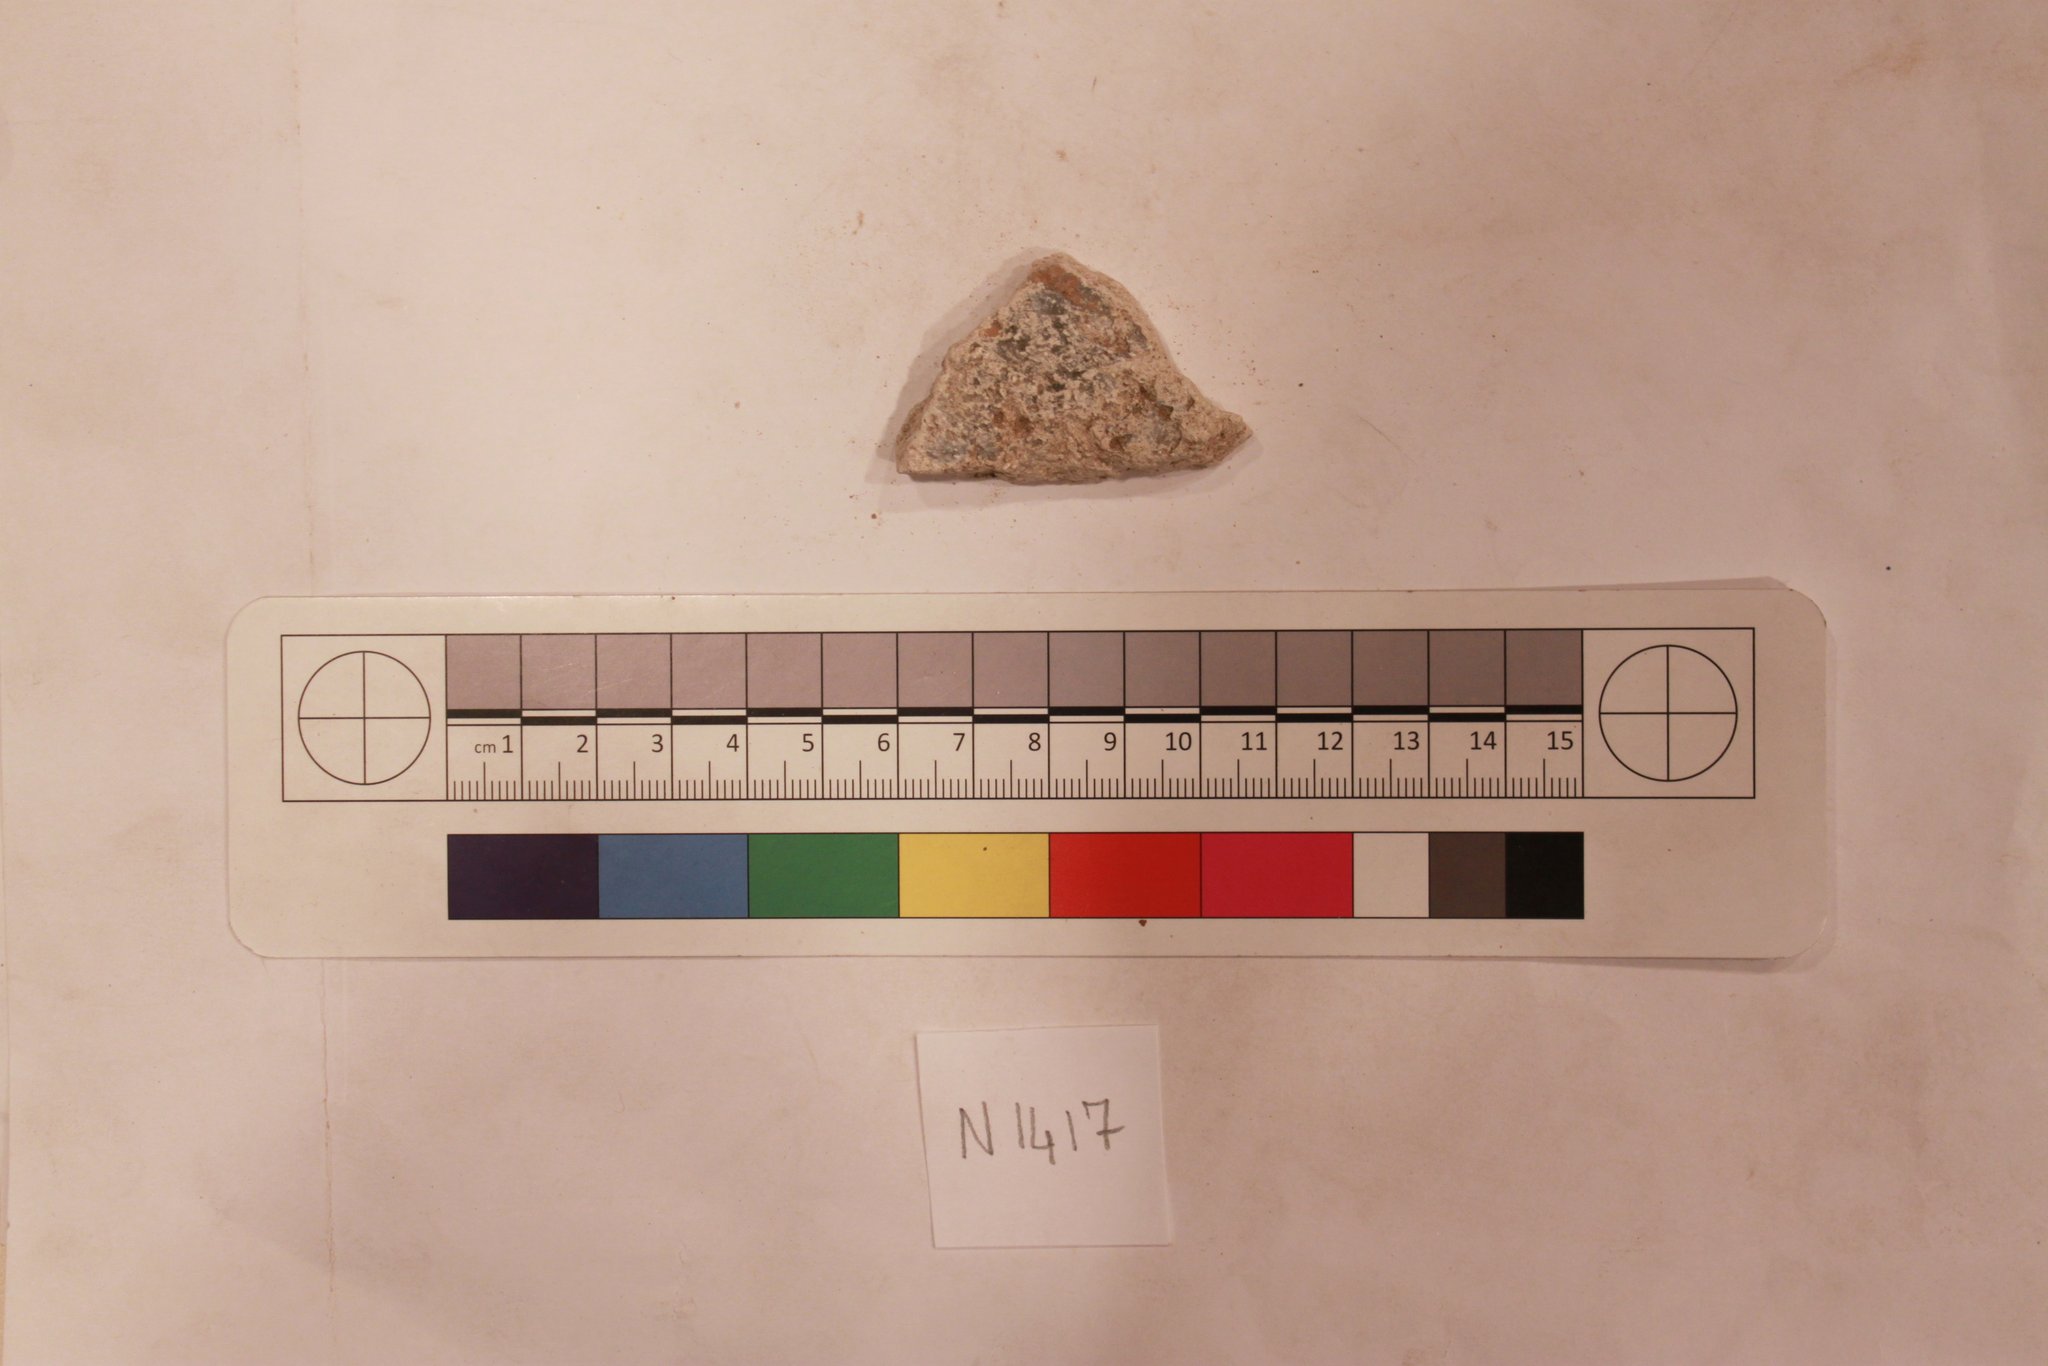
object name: fragment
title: Stucco Fragment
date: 701-1200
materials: plaster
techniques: carving, painting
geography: iran